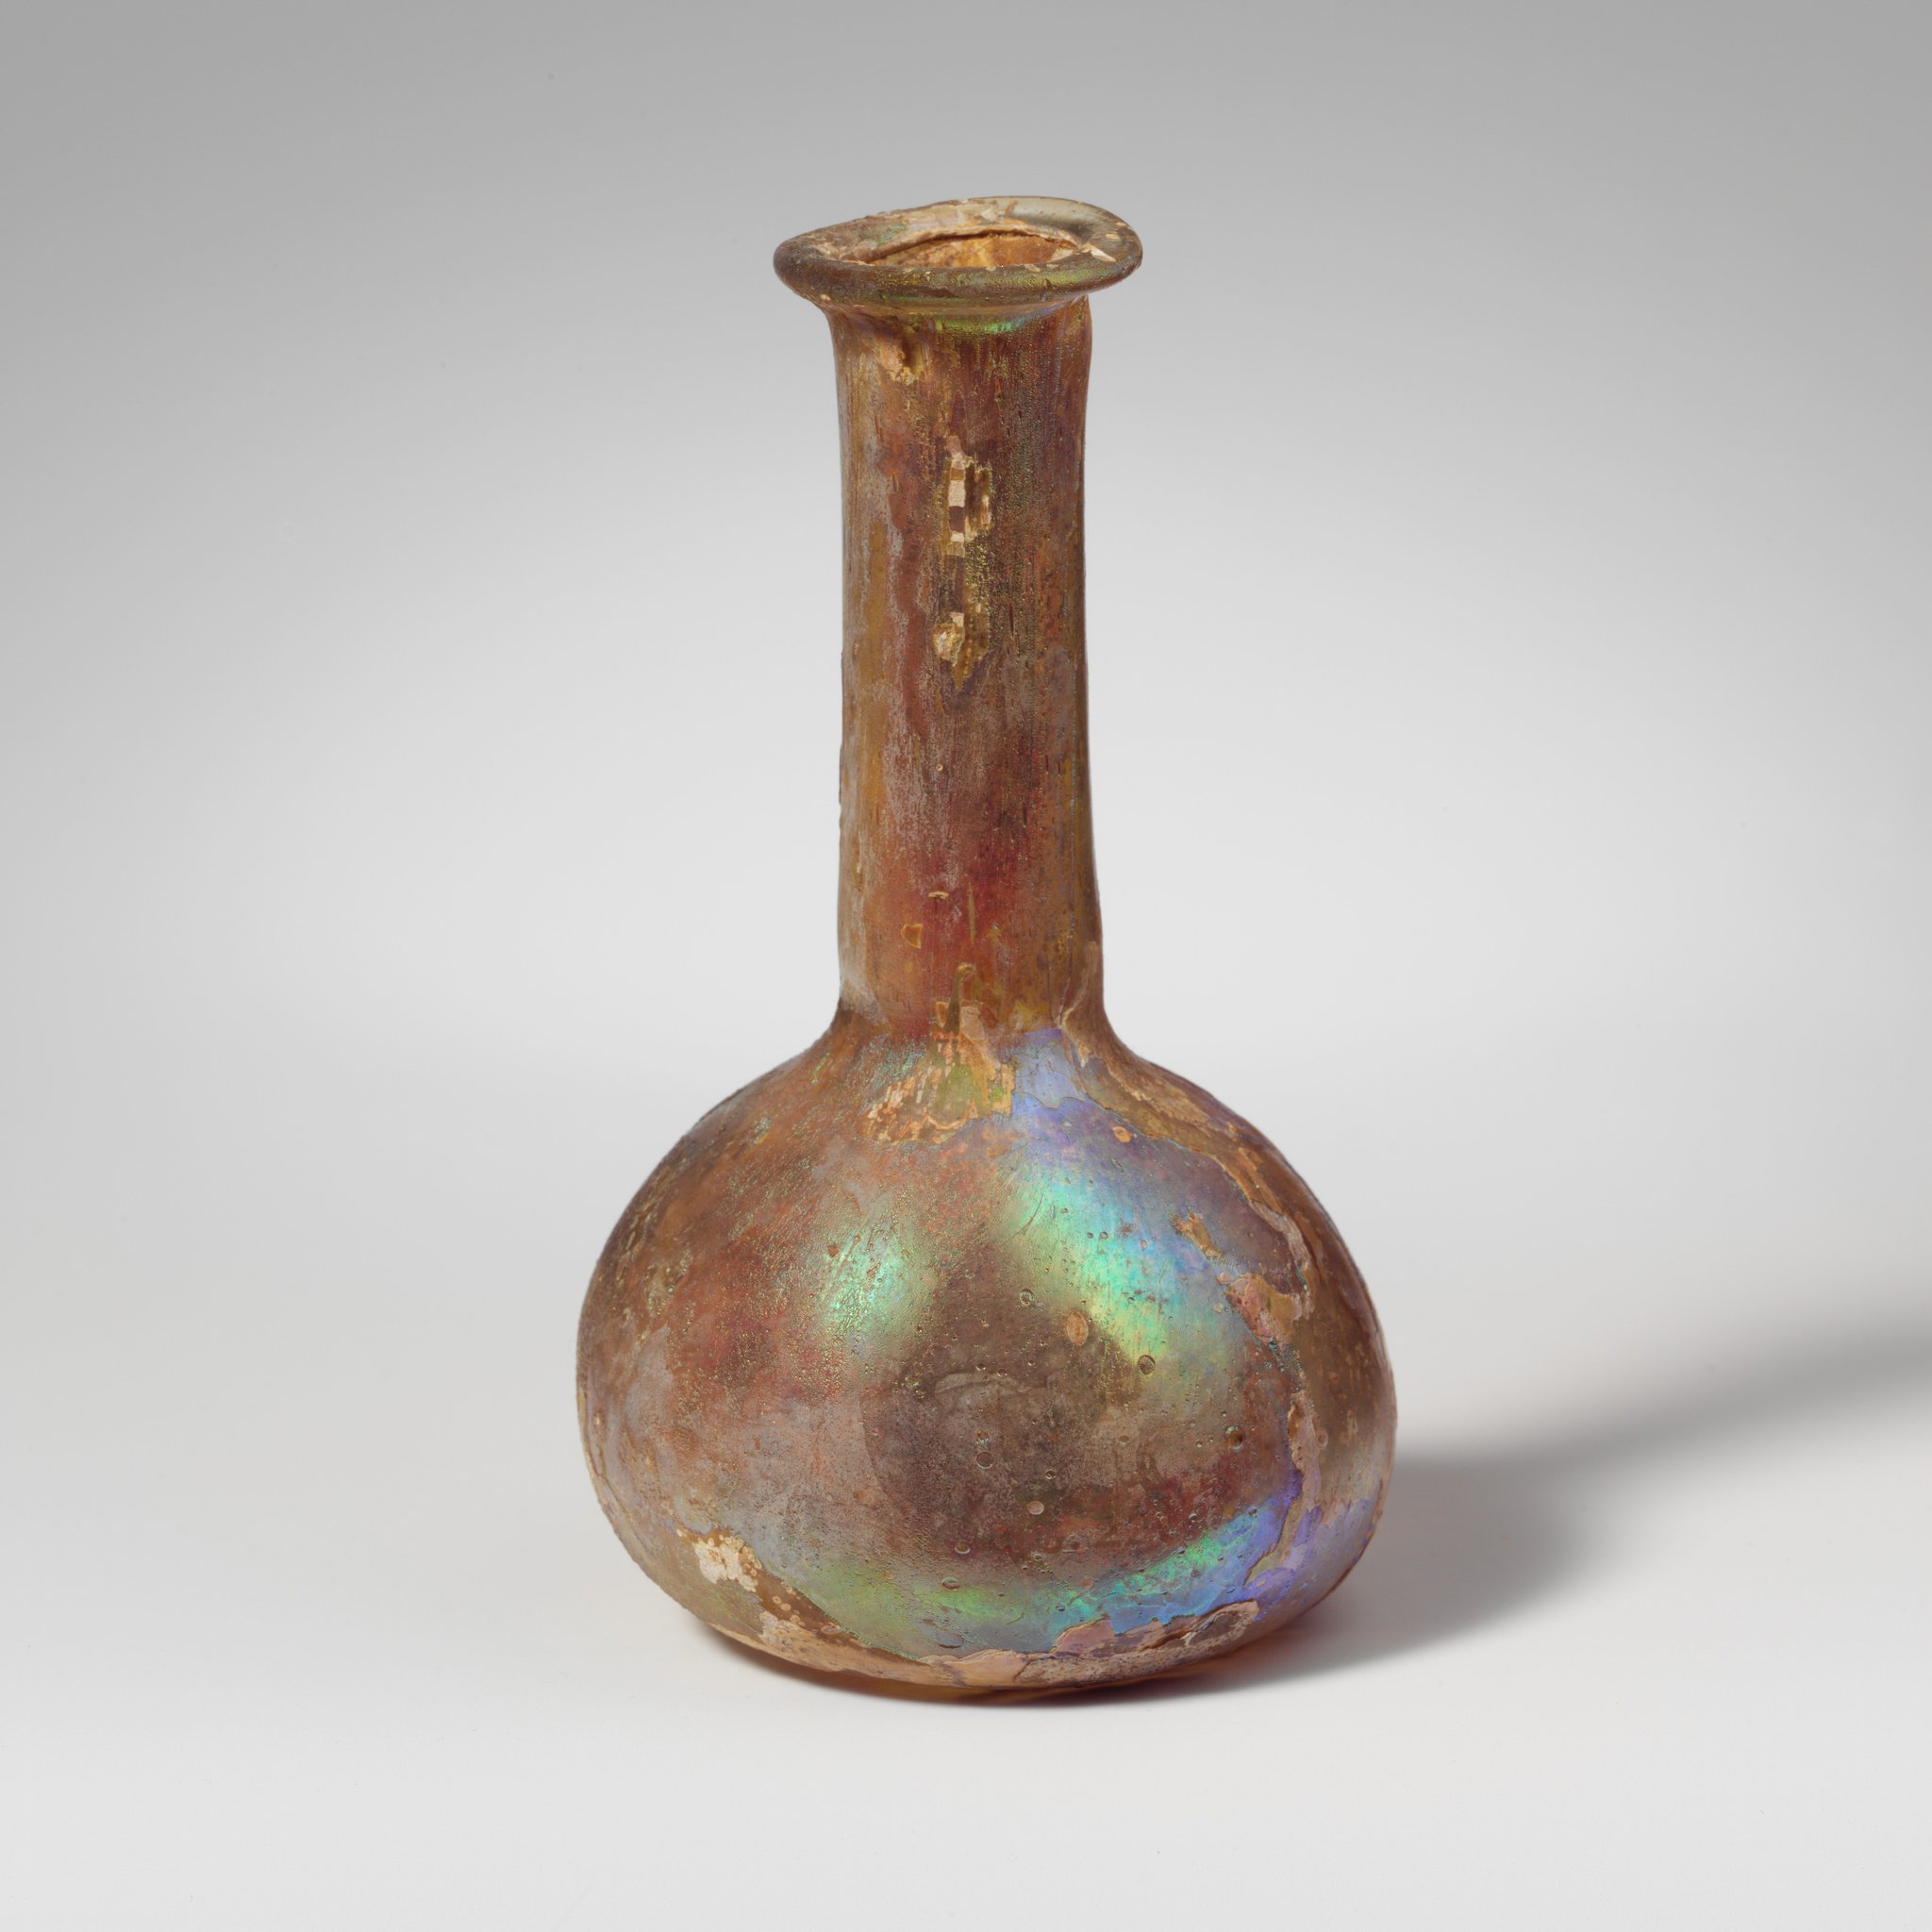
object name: perfume bottle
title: Glass perfume bottle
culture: roman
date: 101-300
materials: glass